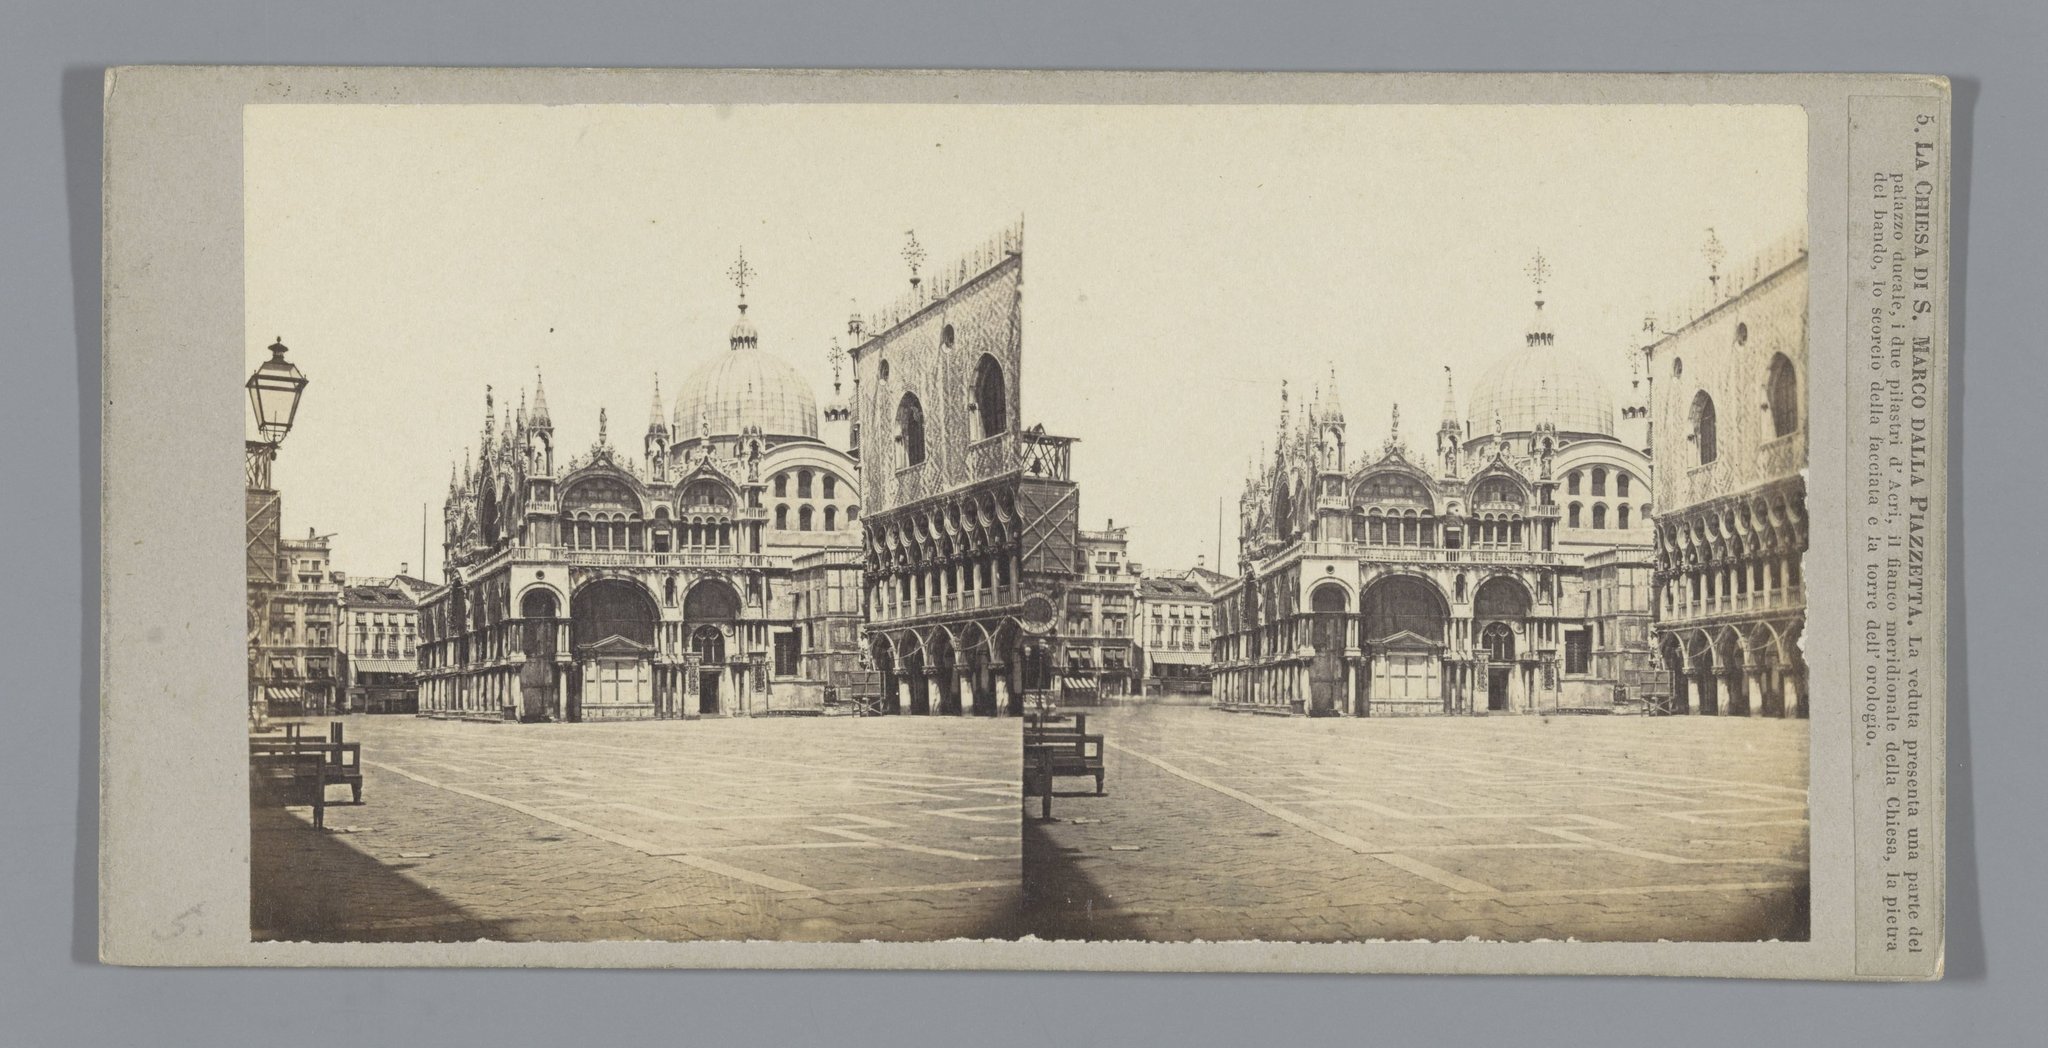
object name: stereograph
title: La Chiesa di S. Marco dalla Piazzetta.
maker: Anonymous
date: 1850-1870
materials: cardboard, photographic support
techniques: albumen print, photography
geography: san marco square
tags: church (exterior), façade (of house or building)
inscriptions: number: ‘5.’, inscription: ‘La veduta presenta [...] lo scorcio della facciata e la torre dell'orologio.’